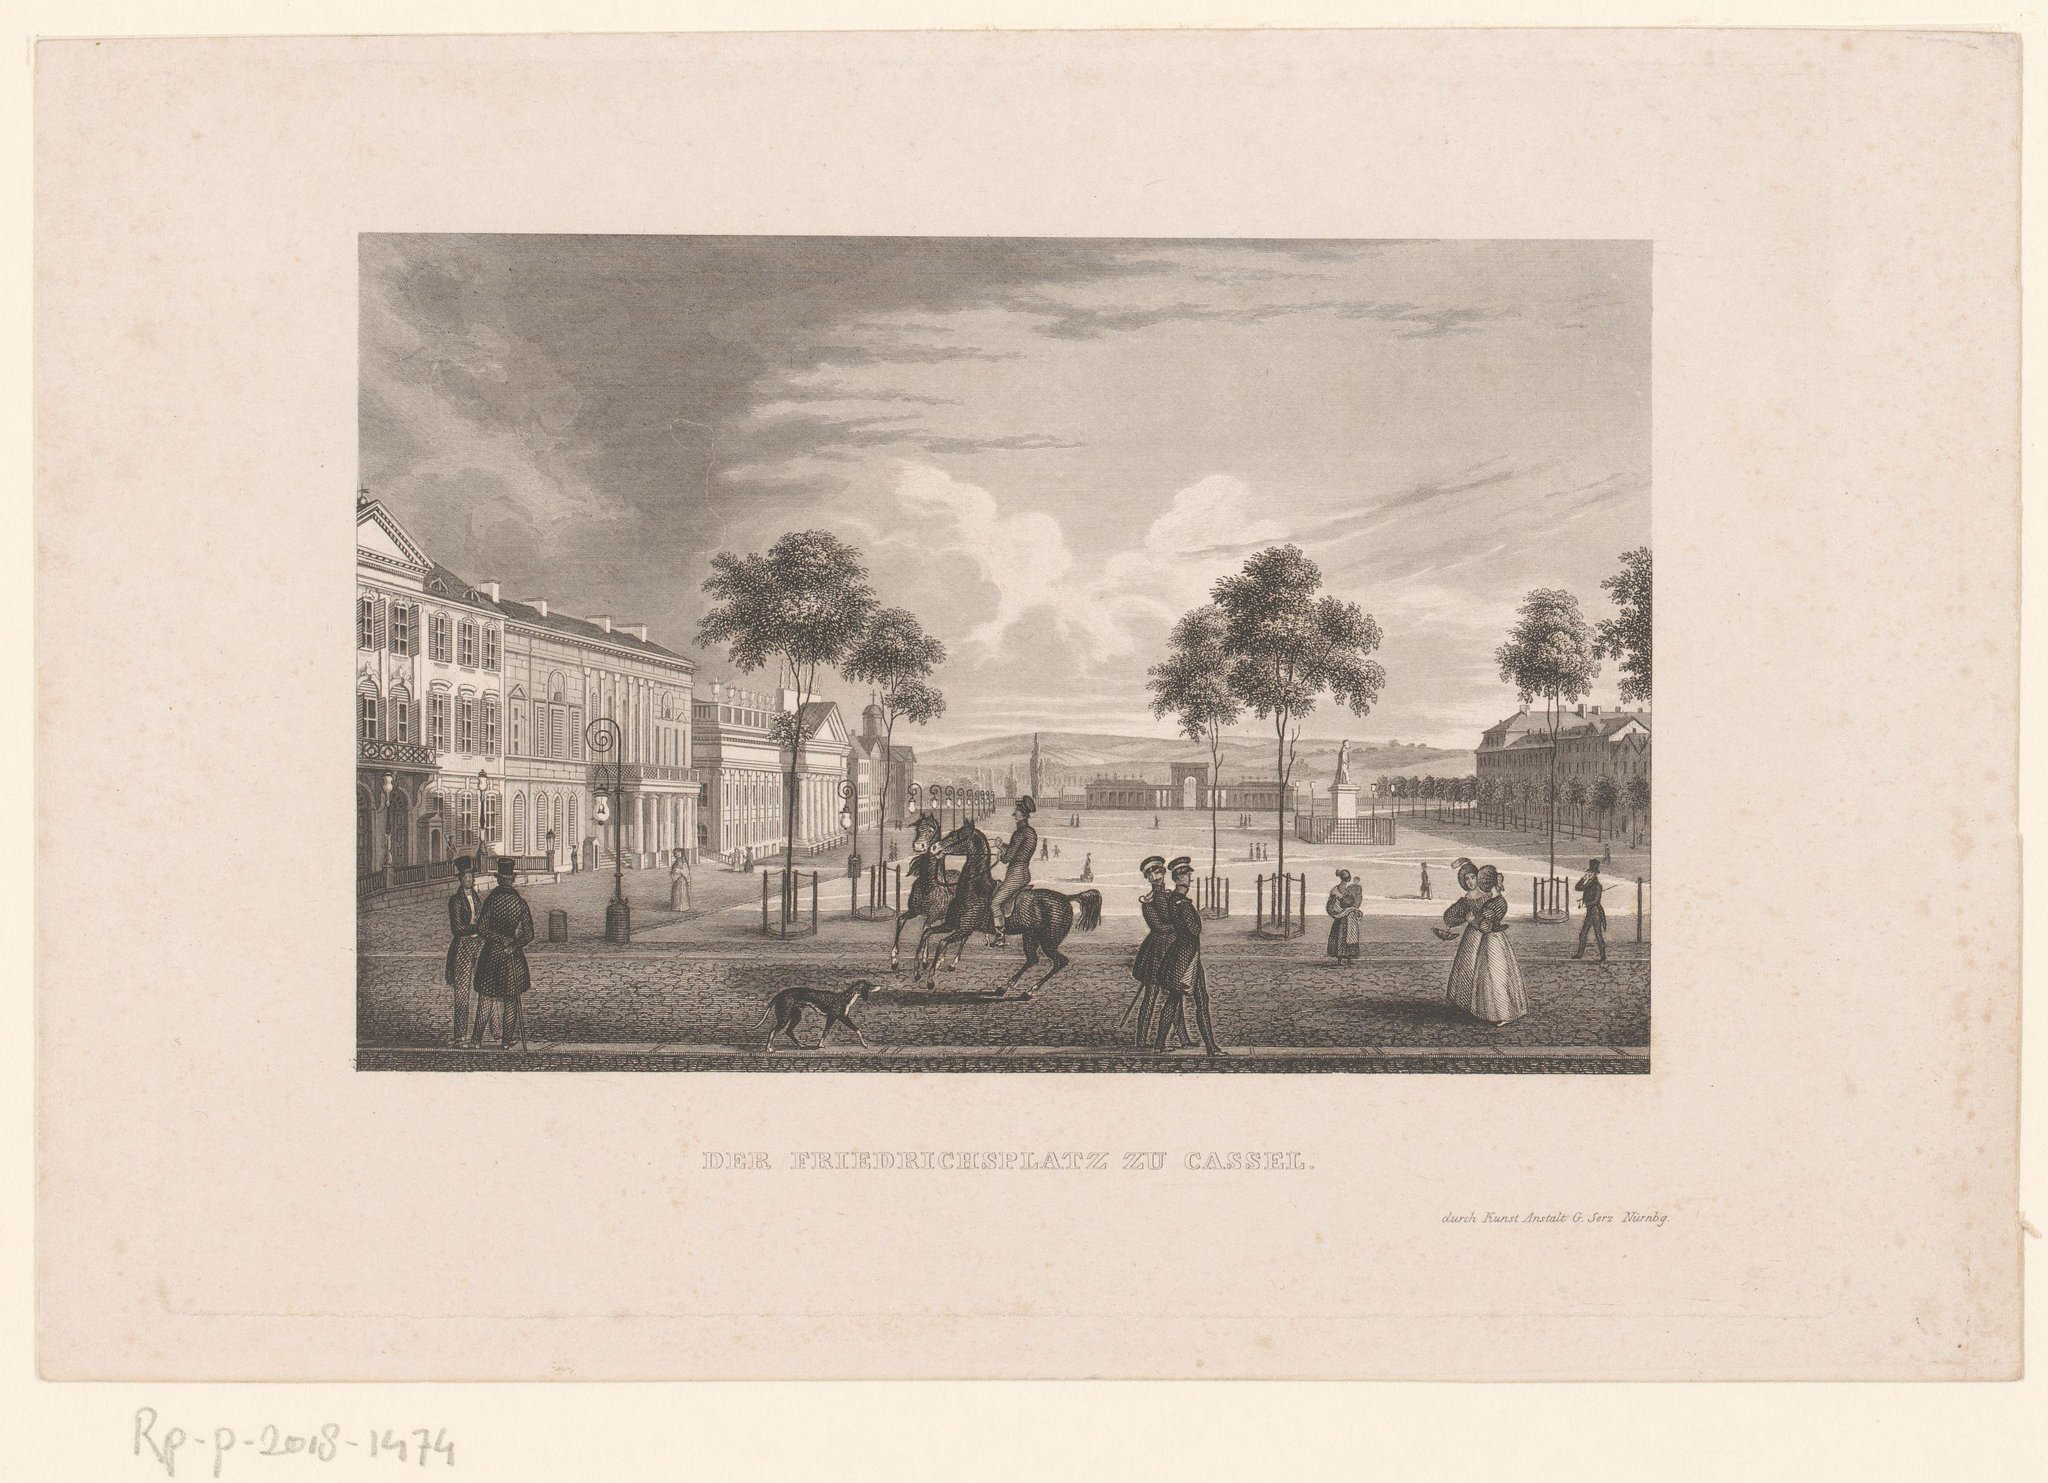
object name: print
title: Gezicht op het Friedrichsplatz, te Kassel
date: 1820-1848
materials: paper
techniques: engraving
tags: square, place, circus, etc.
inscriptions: collector's mark: Lugt 2228